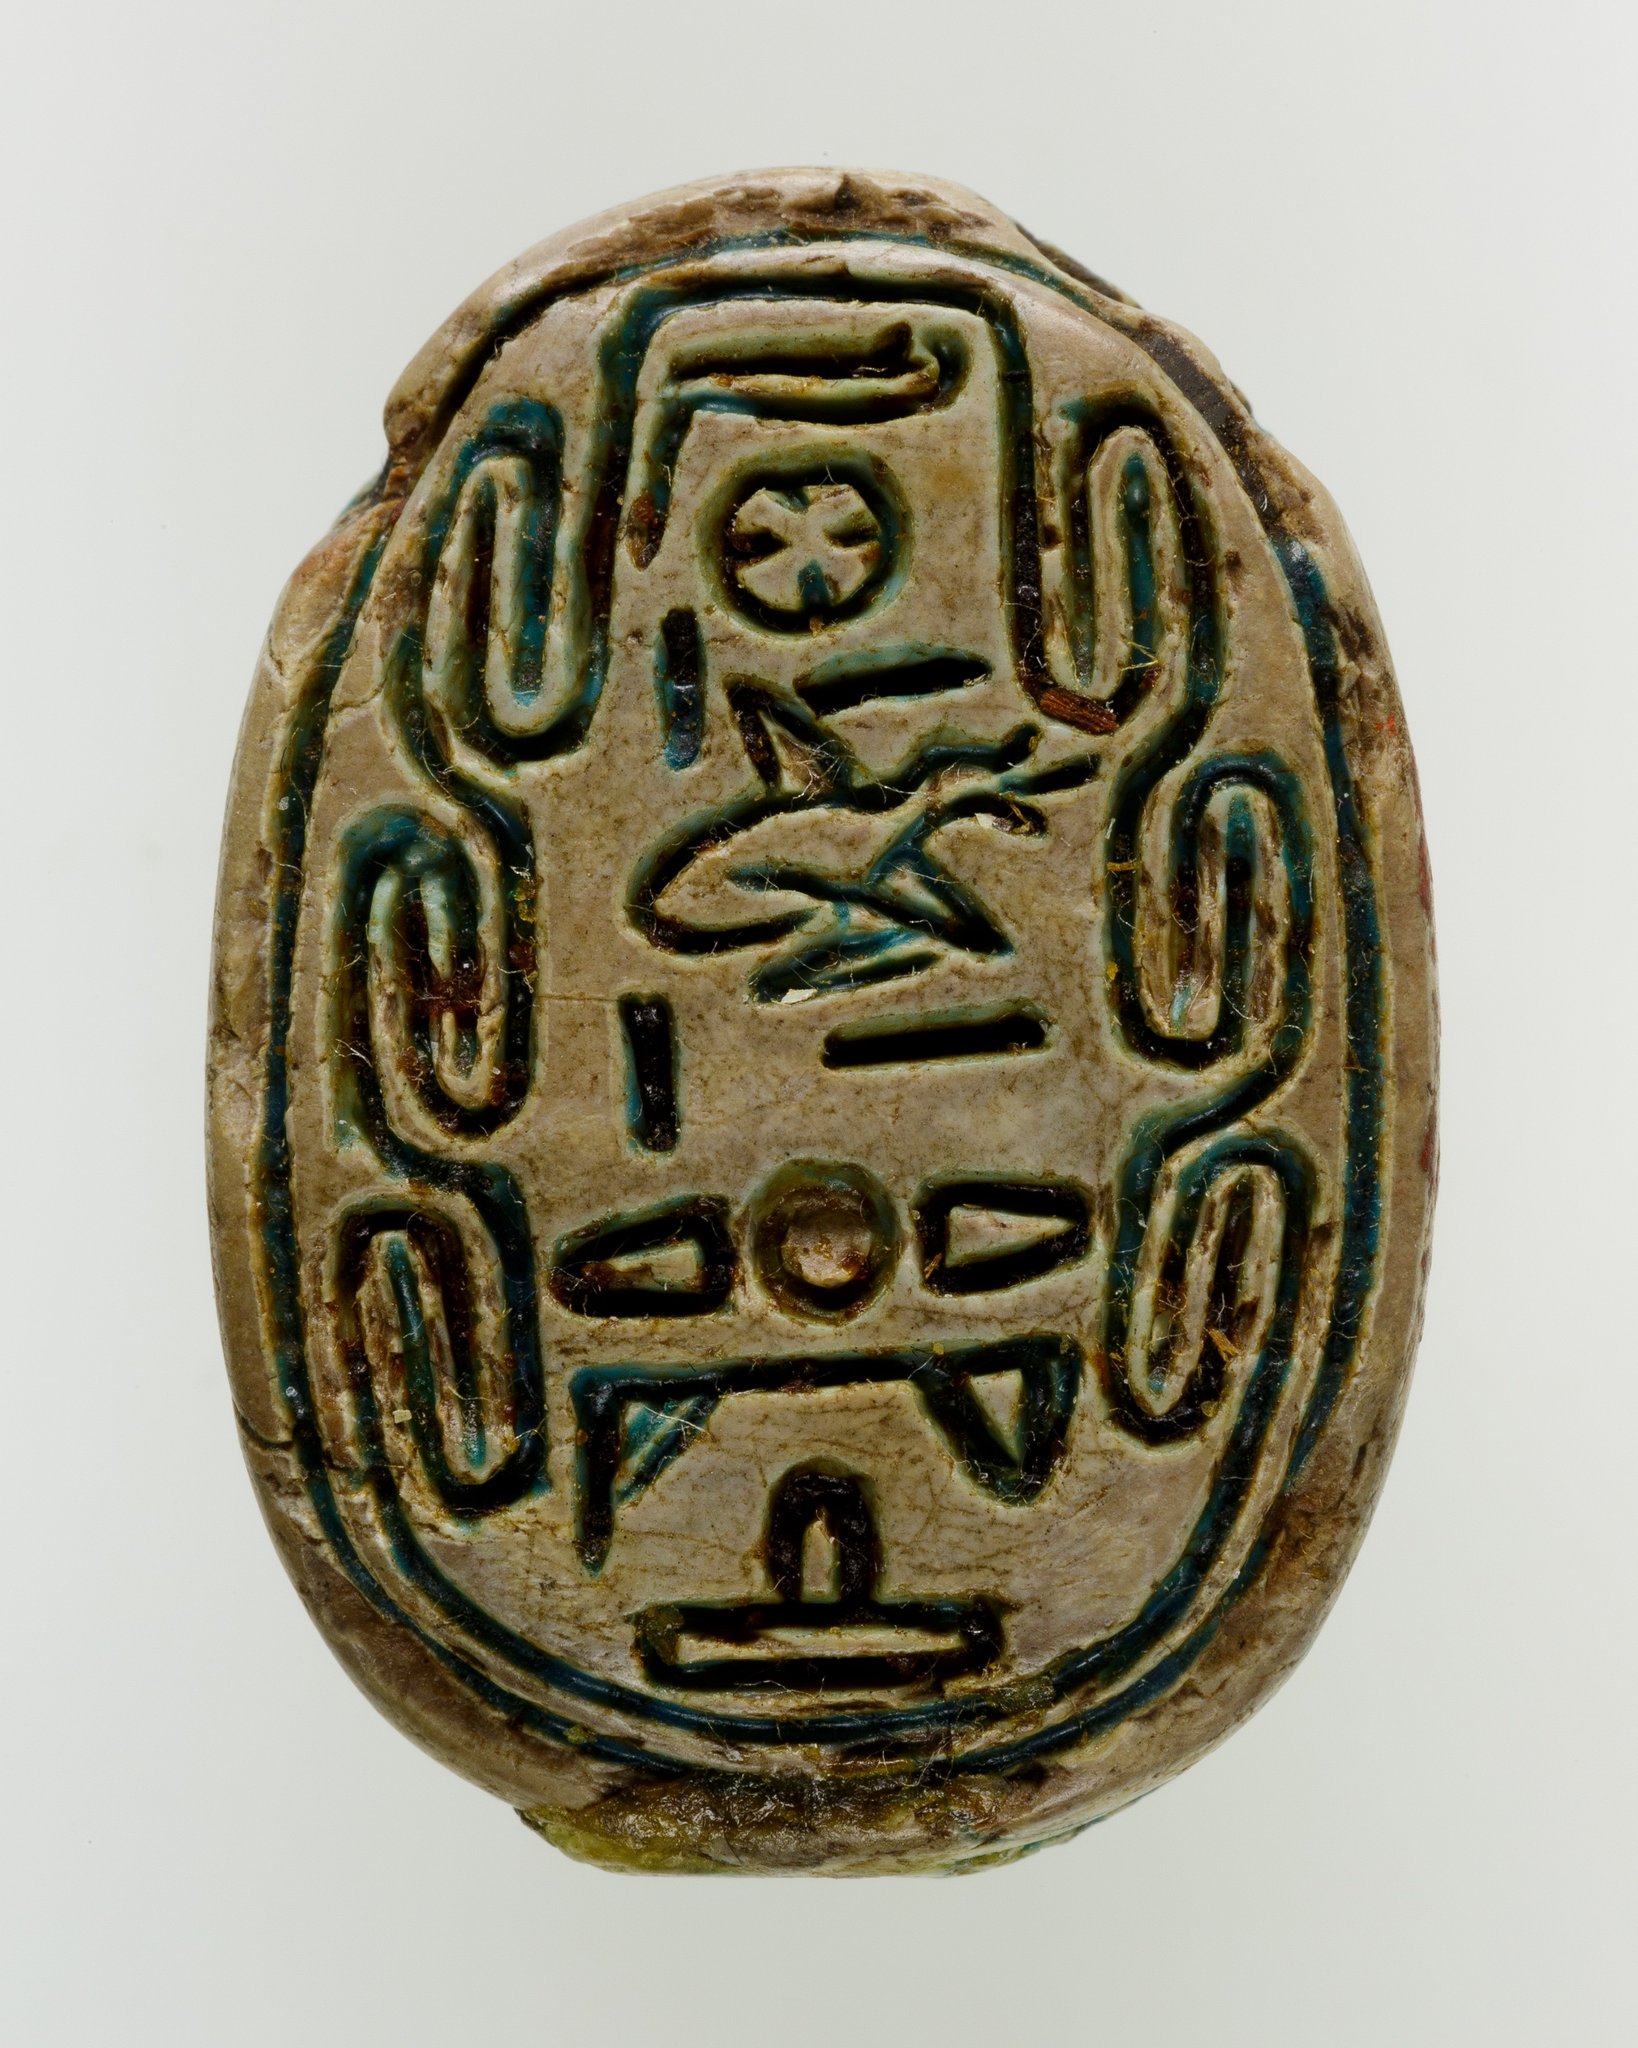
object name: scarab, minhotep, scroll border, vizier, private name and title, official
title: Scarab of the Vizier Minhotep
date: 1760-1670 BCE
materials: stone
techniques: glazing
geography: egypt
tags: hieroglyphs,scarabs